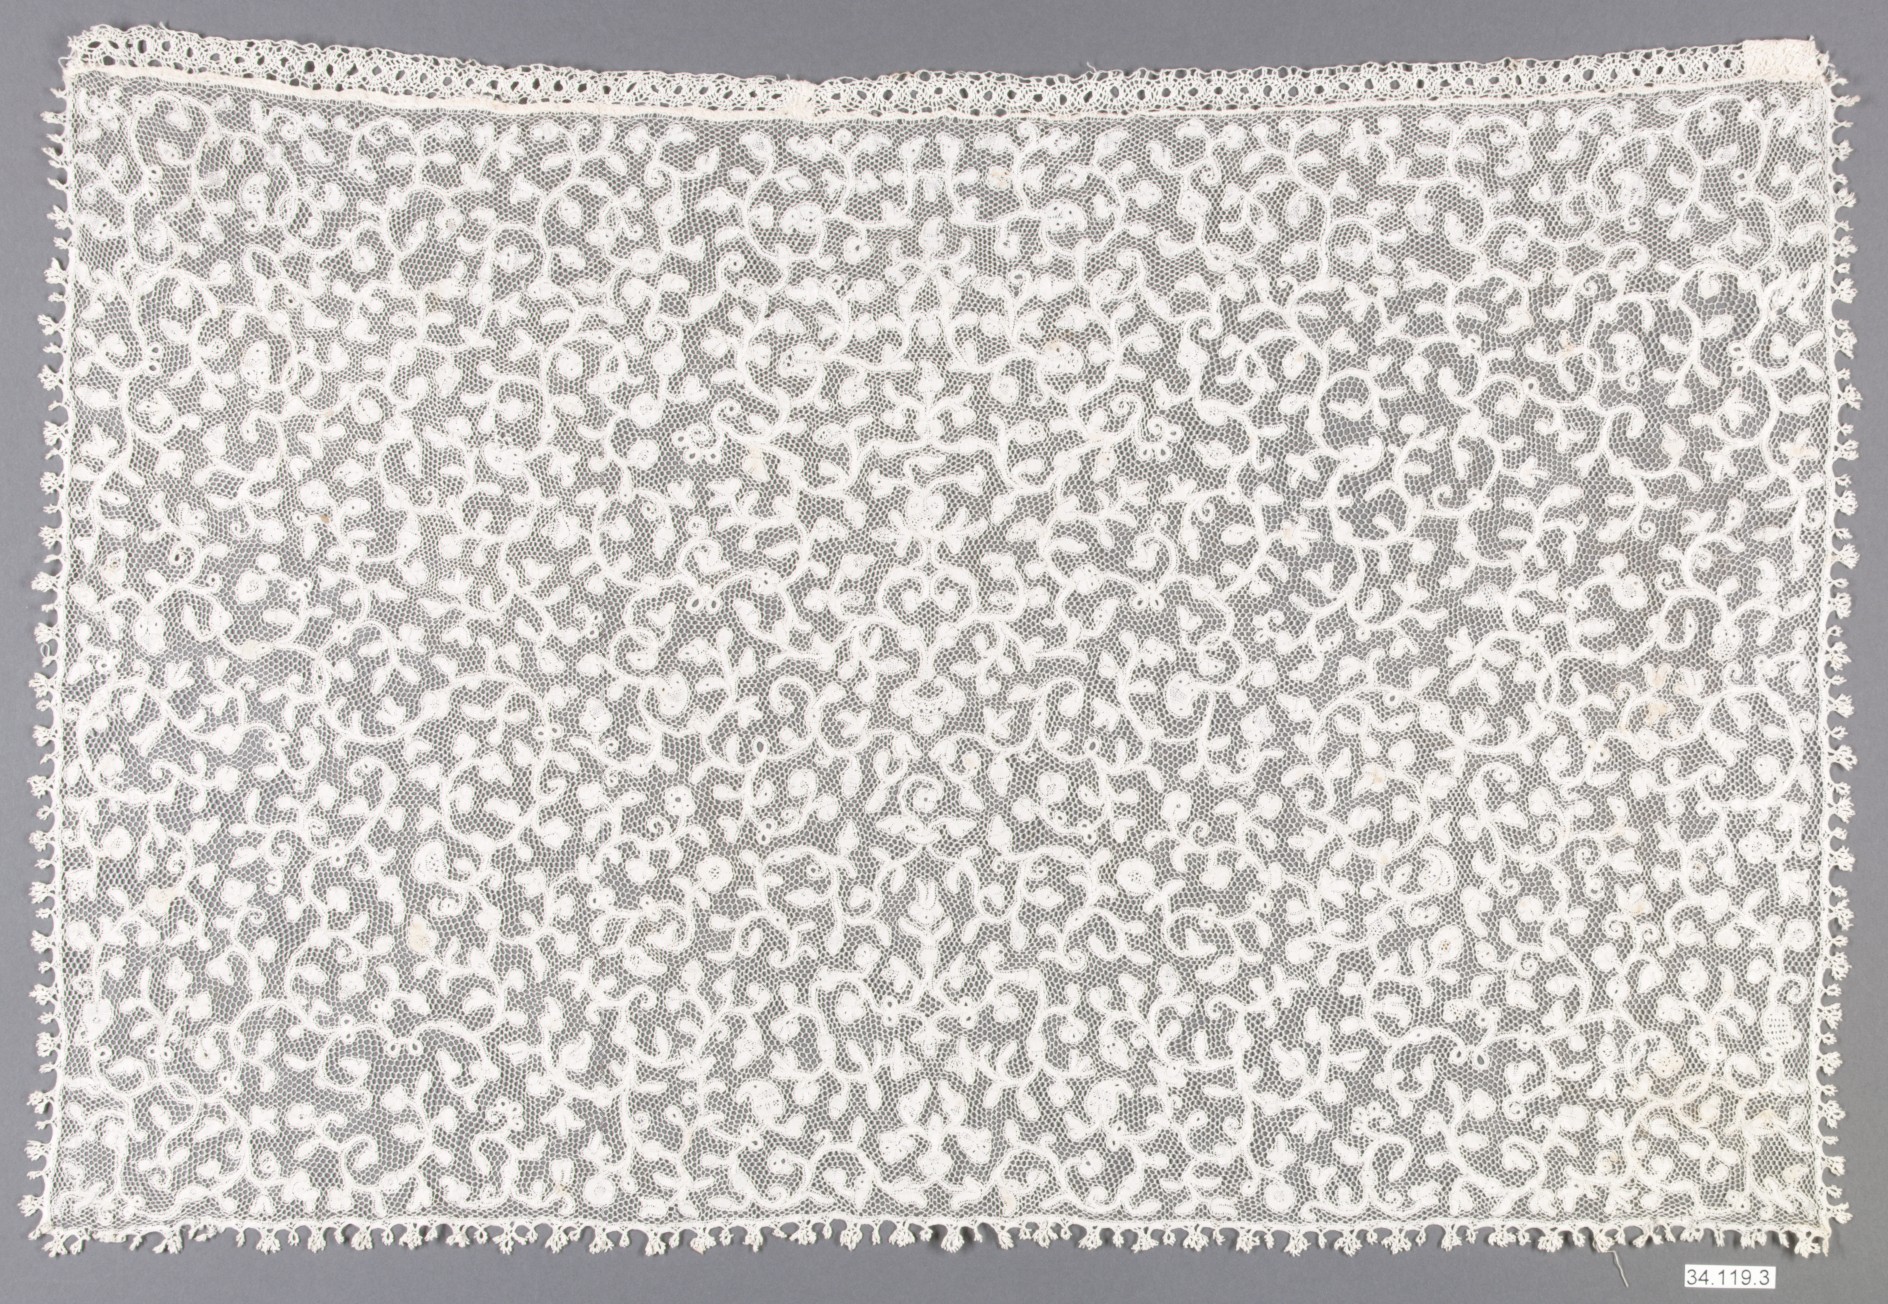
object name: cravat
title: Cravat (one of a pair)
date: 1701-1733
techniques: lace